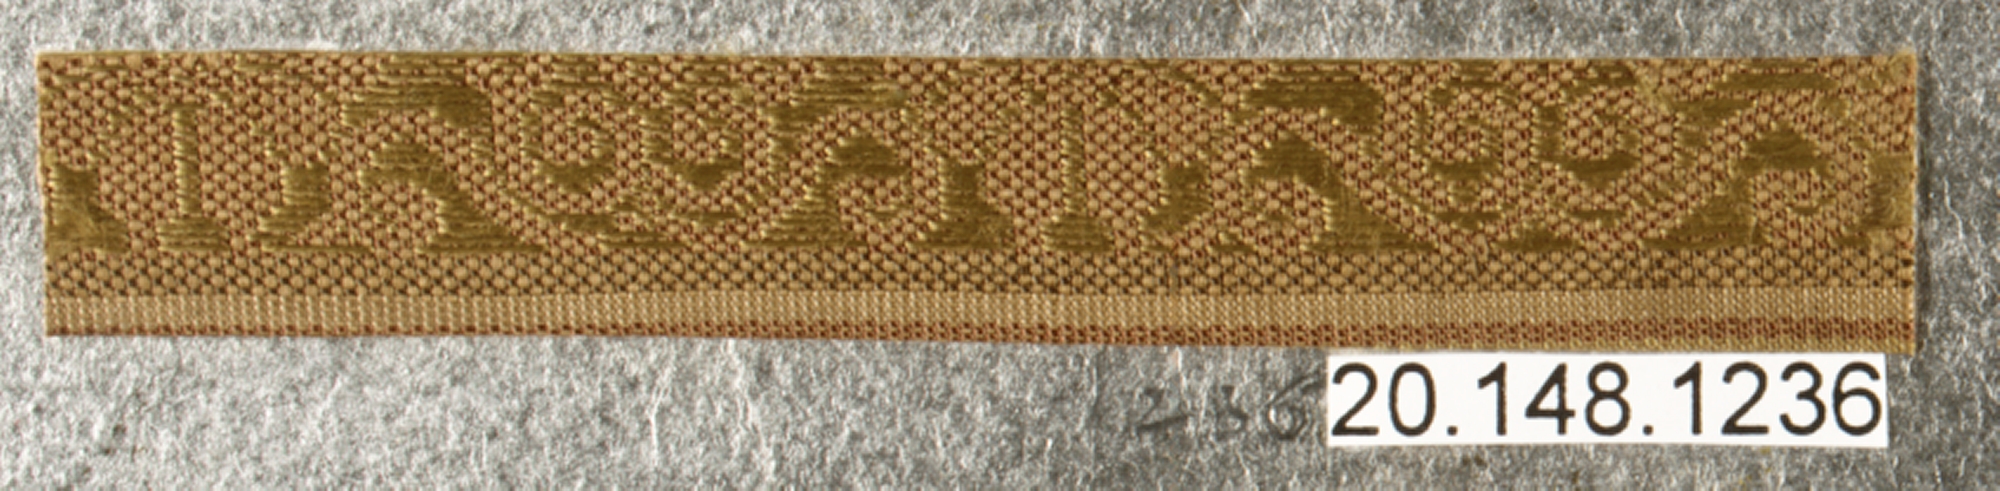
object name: piece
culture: japanese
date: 1801-1900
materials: silk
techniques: compound weave